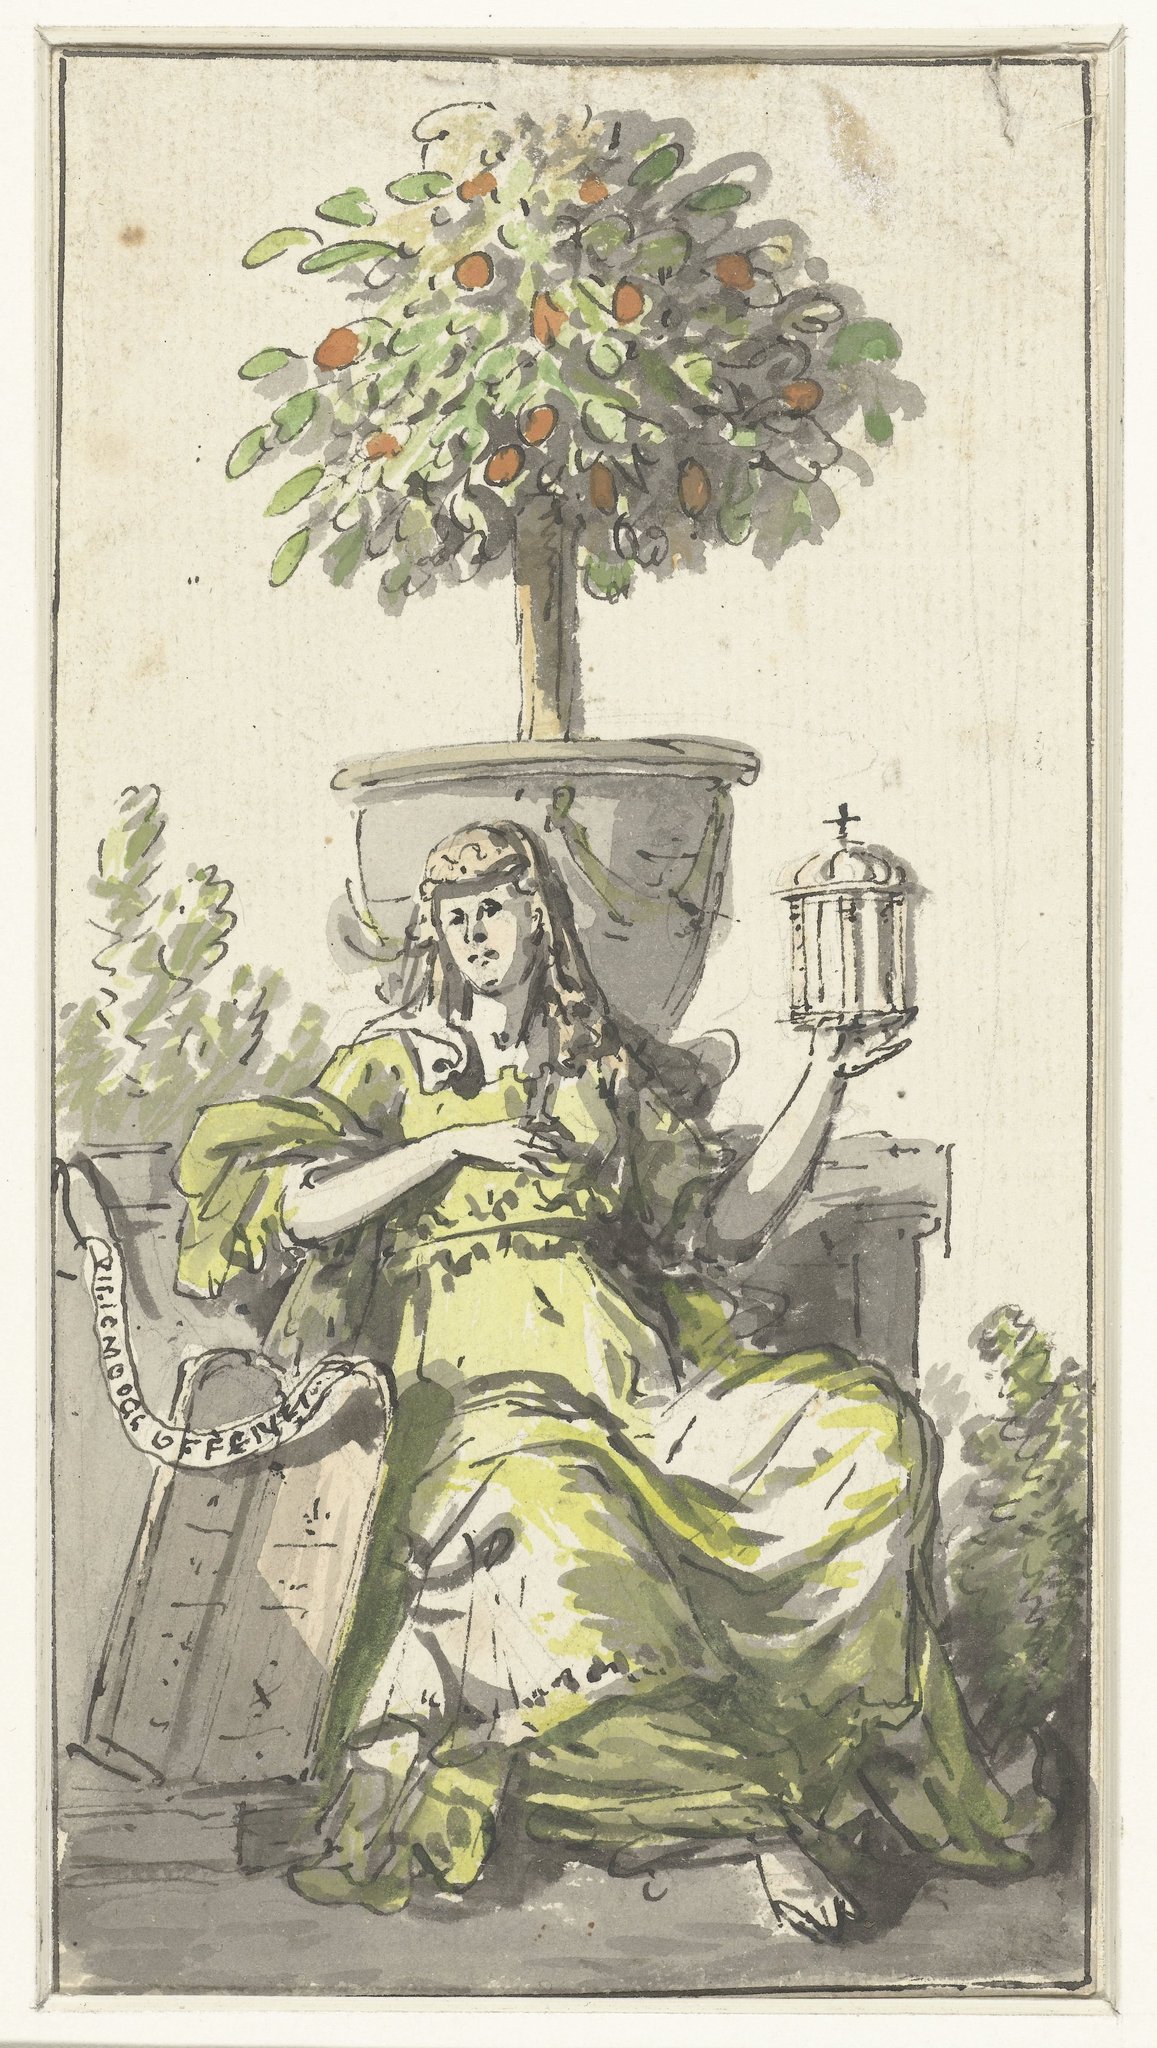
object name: design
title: Ontwerp voor een titelpagina met een vrouw met een monstrans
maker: abraham van strij (i)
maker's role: draughtsman, painter, print maker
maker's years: 1753-1826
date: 1763-1826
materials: ink, paper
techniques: brush, pen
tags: trees: orange-tree, ostensorium, monstrance, the ten commandments represented together on stone tablets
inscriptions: inscription: ‘A.v.Stry’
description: Vrouw met monstrans, gezeten bij de tafelen der wet voor een oranjeboom. Banderol met opschrift: vici-mooge-offenzi (?).